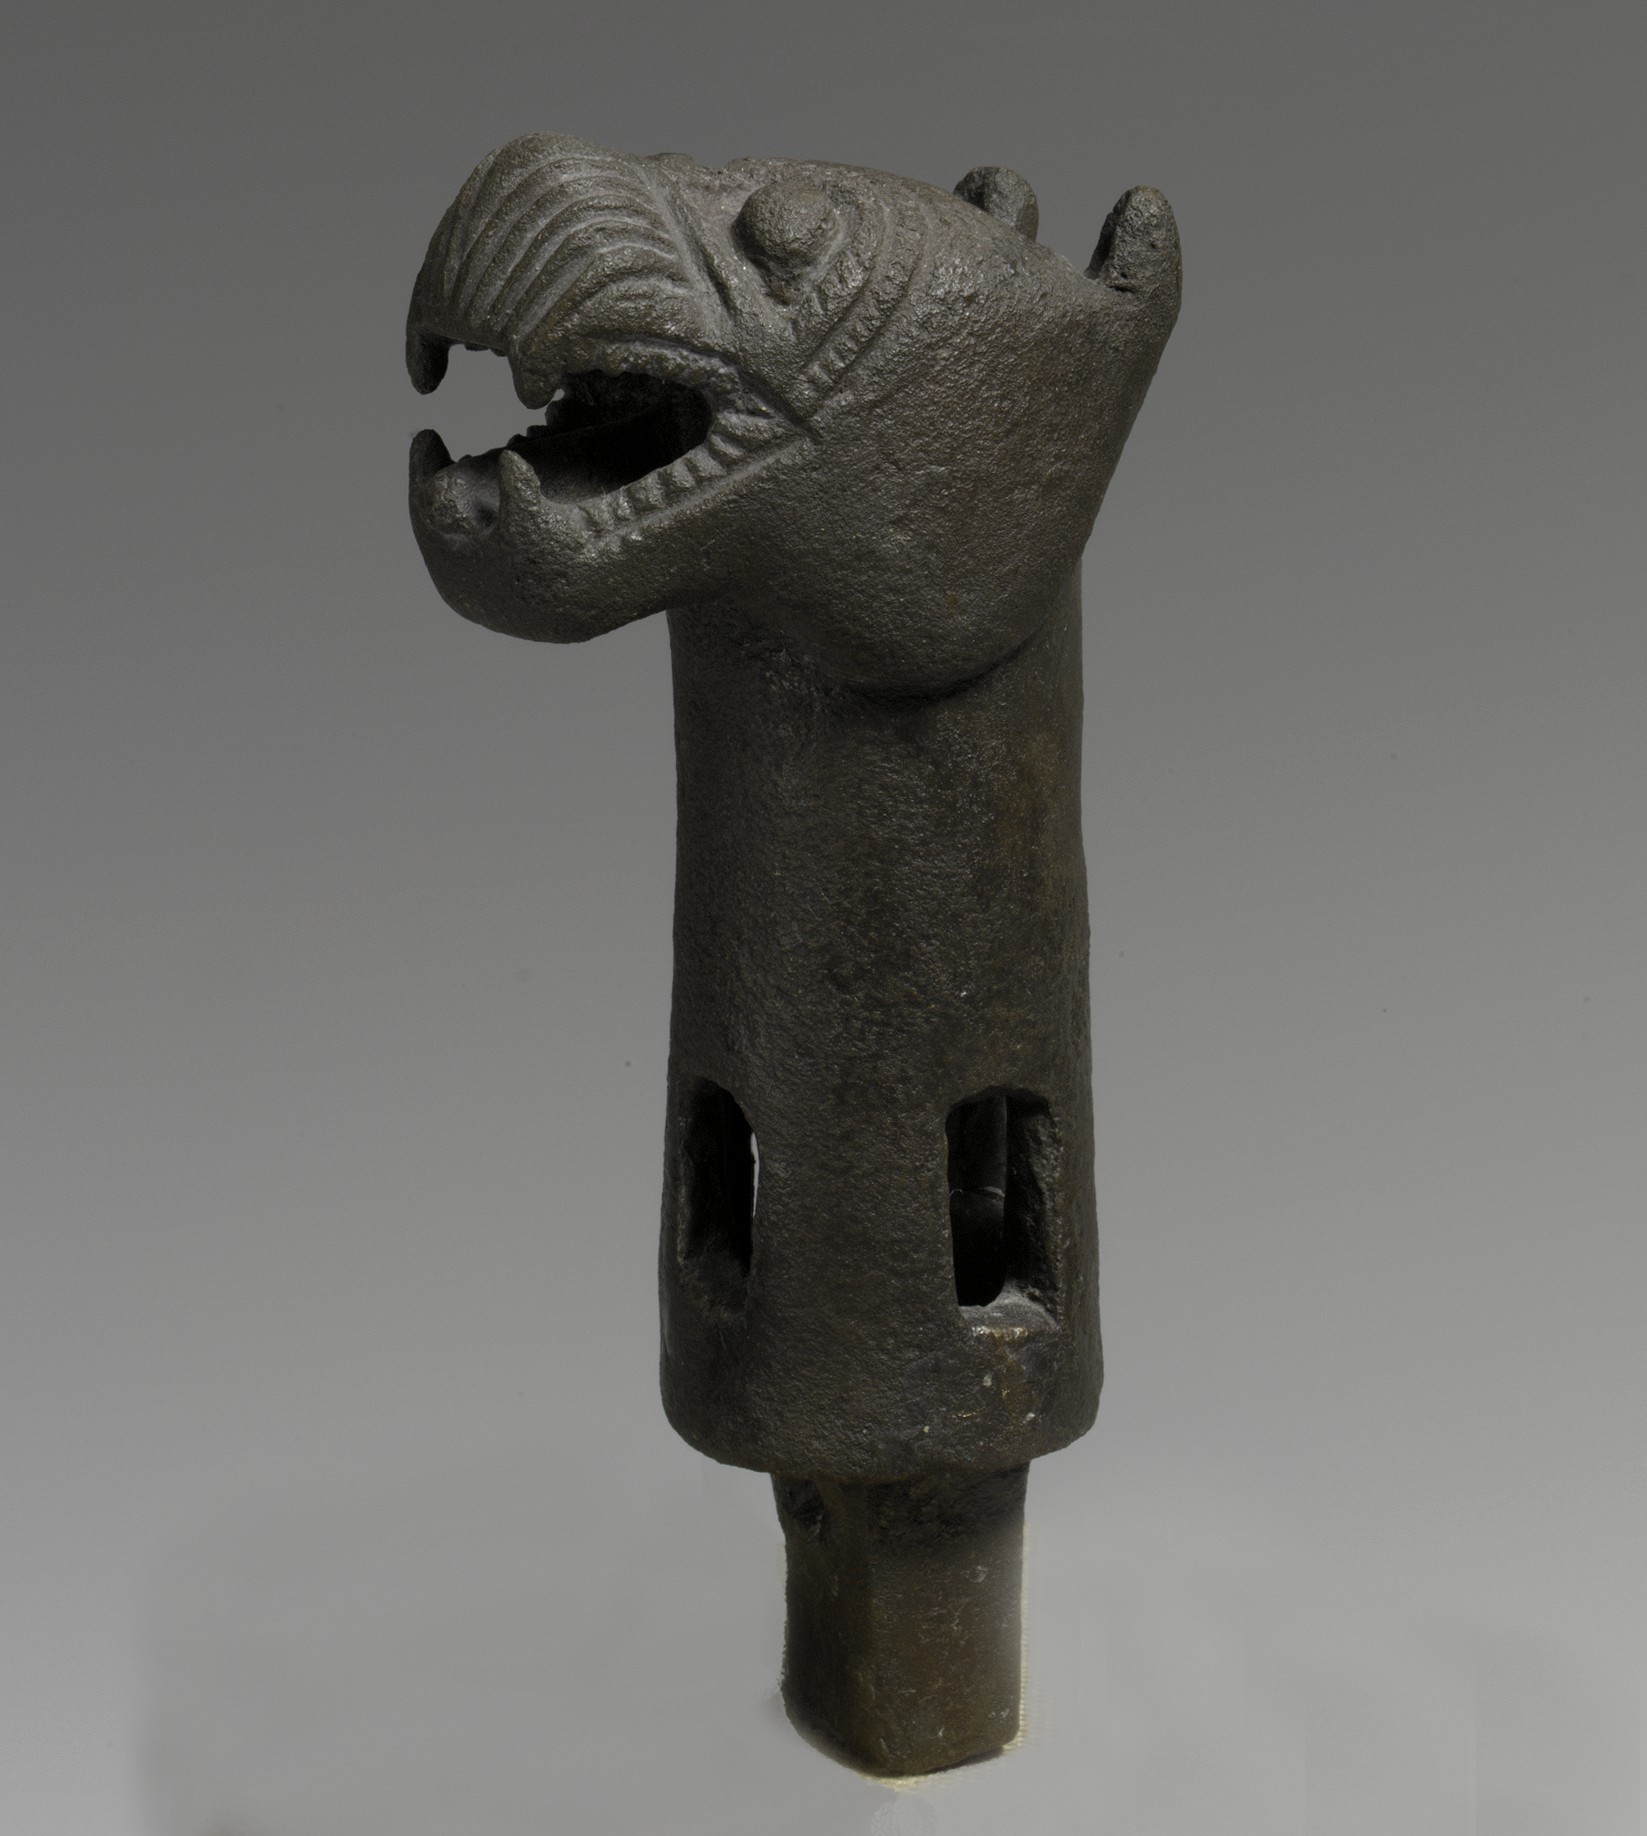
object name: terminal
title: Lion's head terminal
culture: iranian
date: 900-801 BCE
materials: bronze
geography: iran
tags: lions